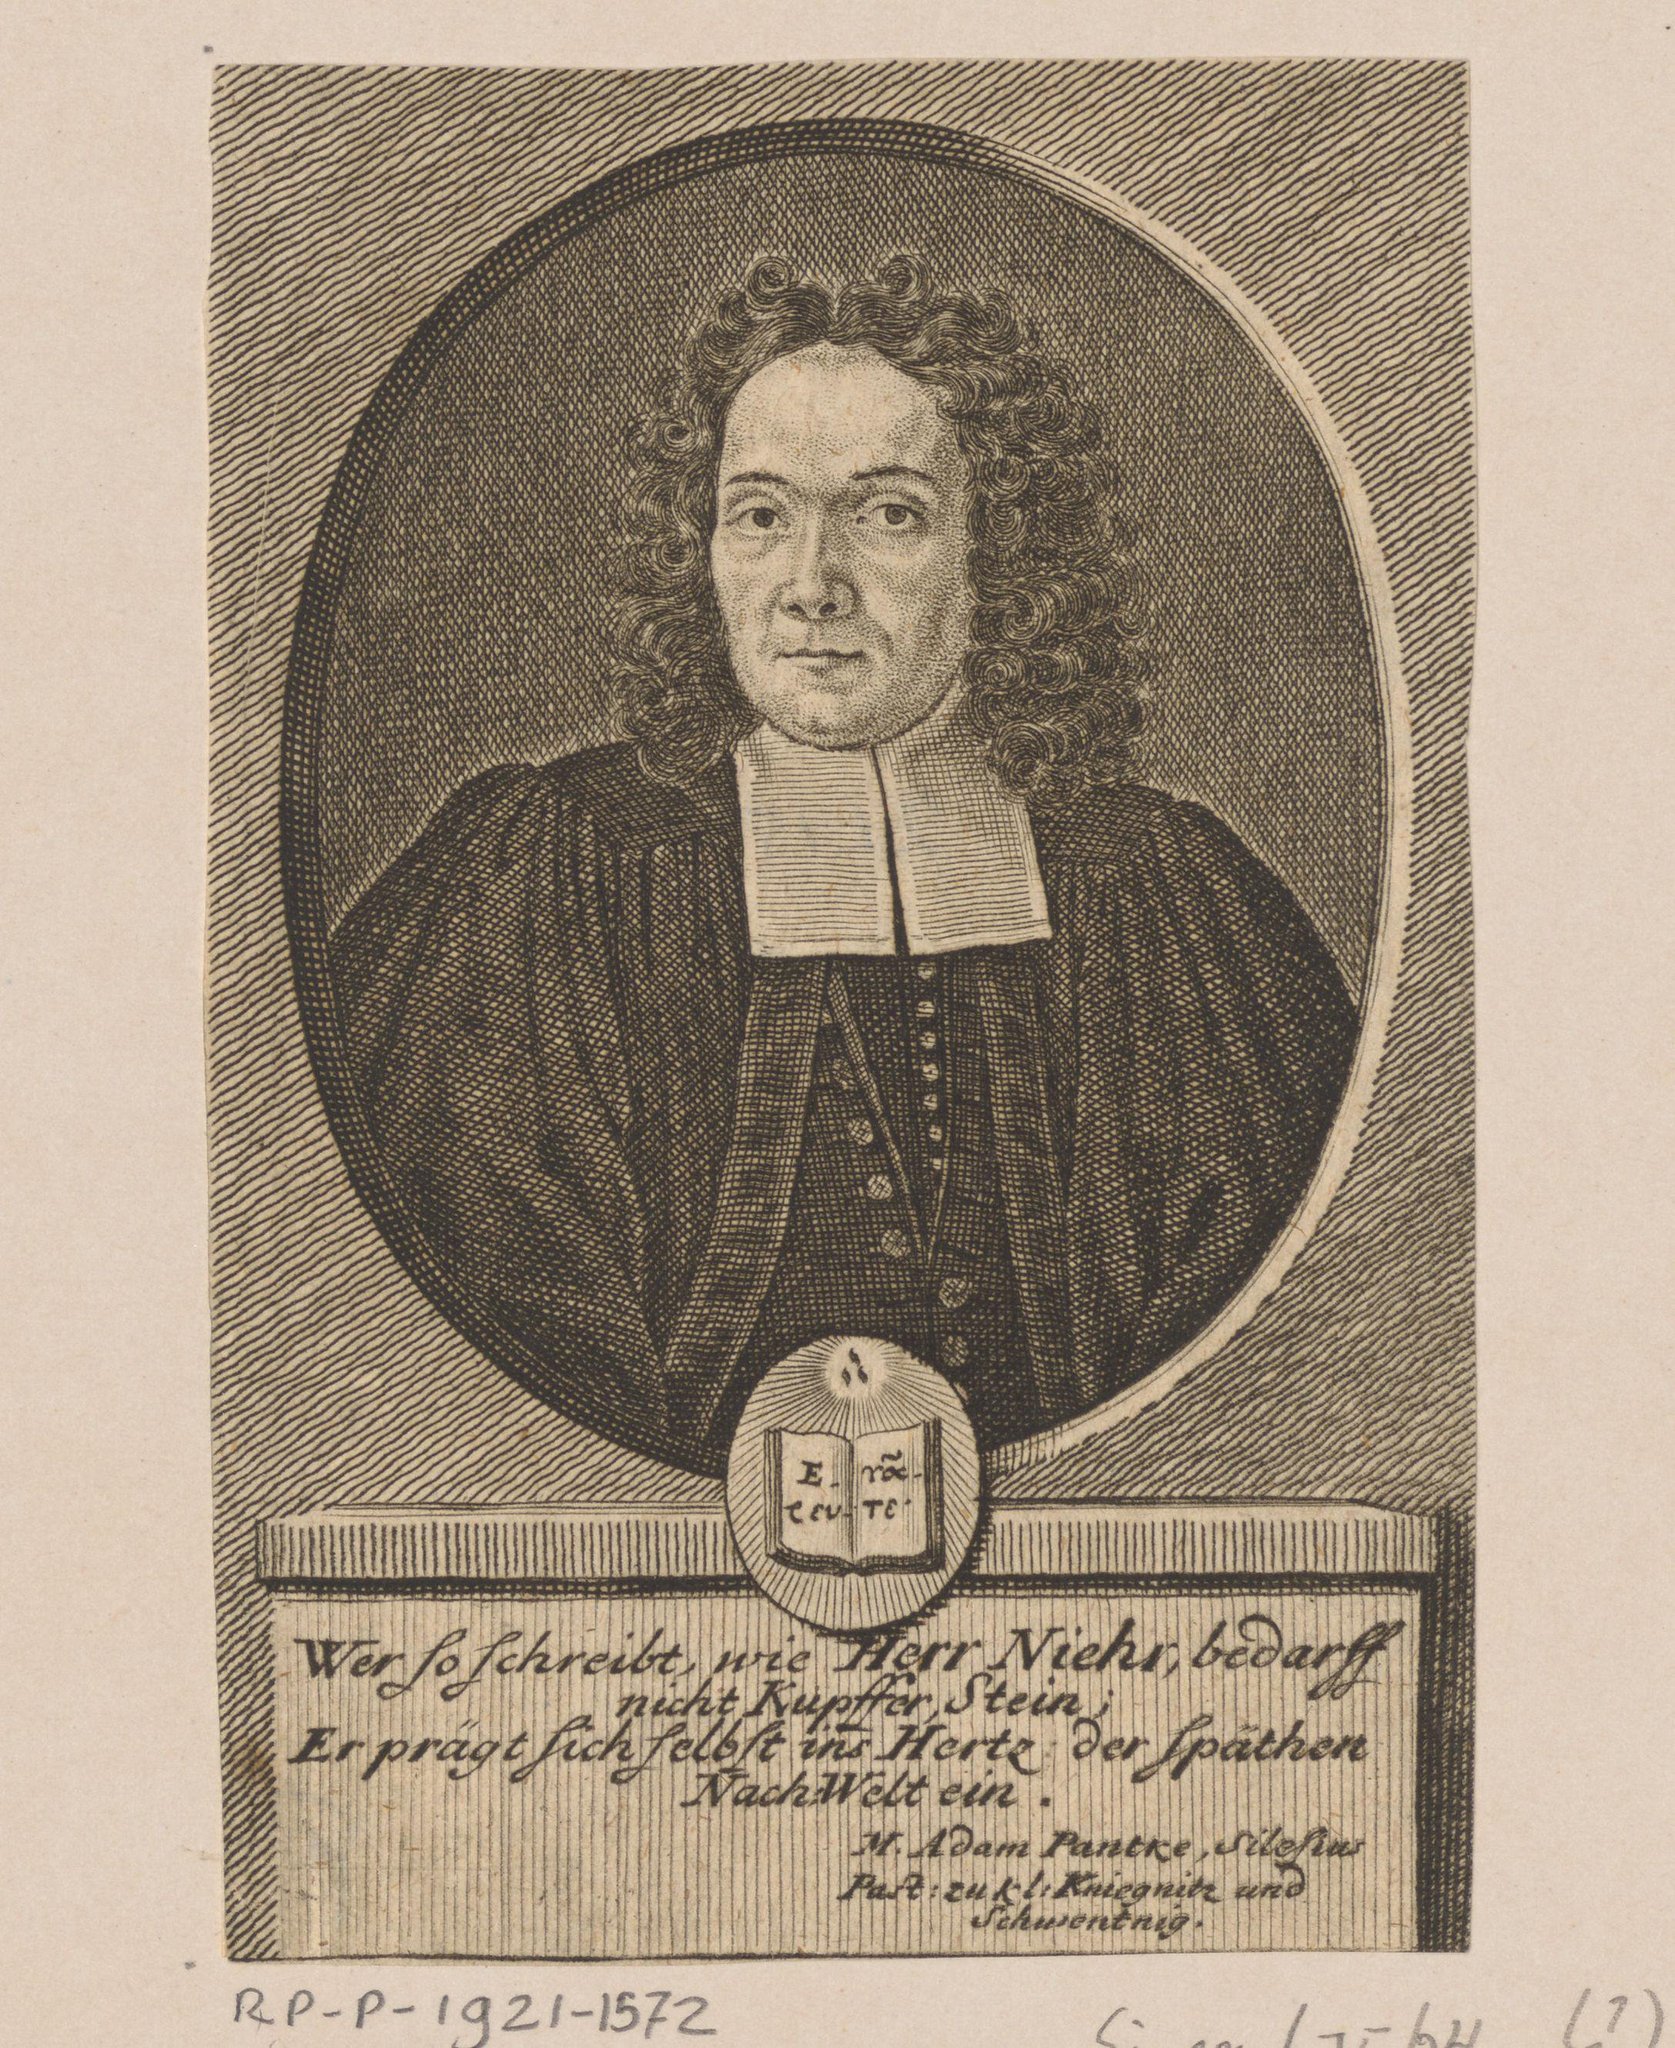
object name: print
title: Portret van N.N. Niehr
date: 1700-1799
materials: paper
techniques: engraving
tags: theologian, historical persons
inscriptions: collector's mark: Lugt 2233